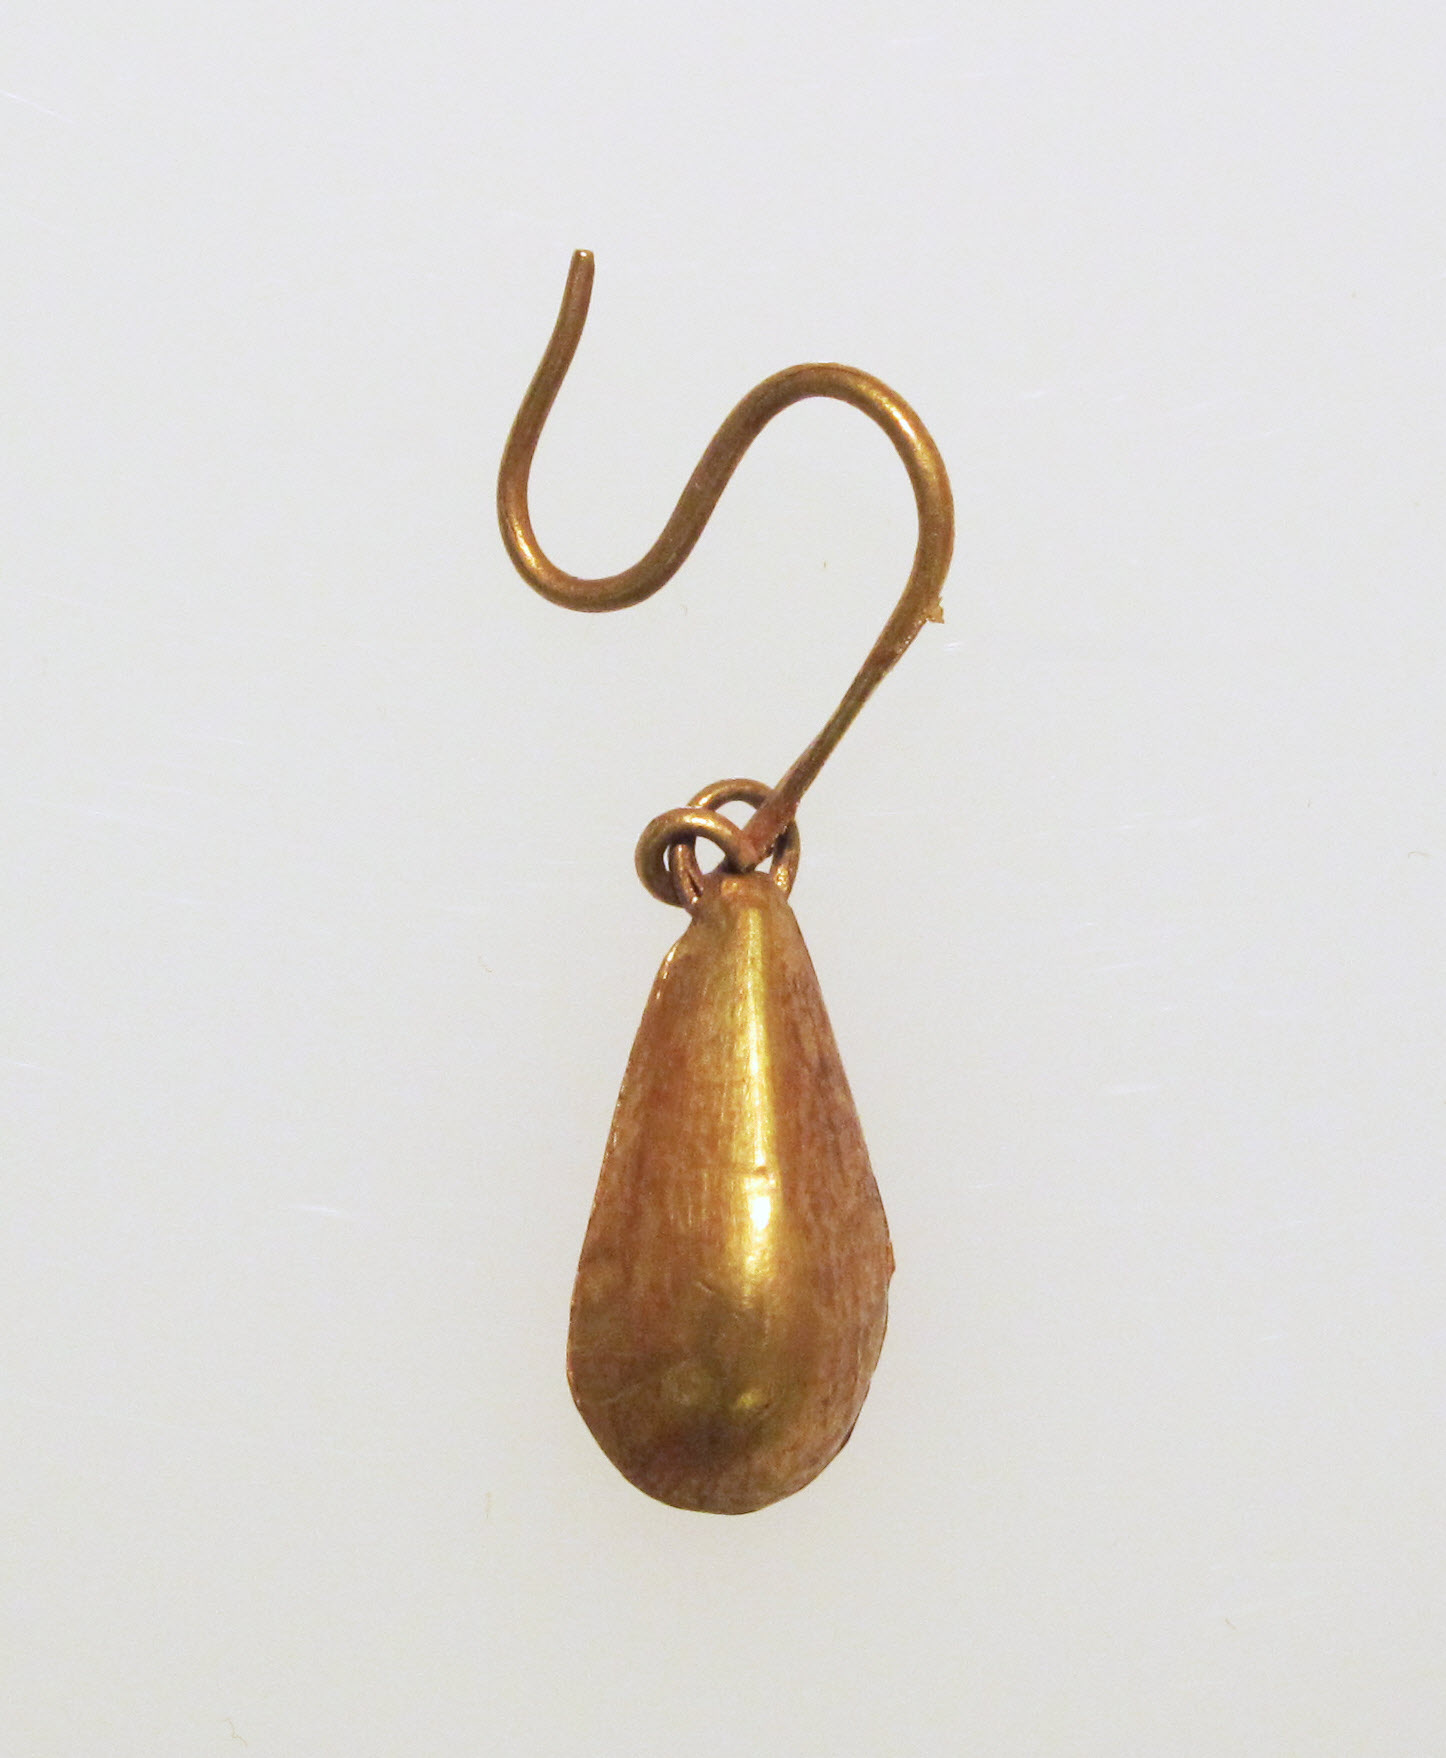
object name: earring hook type with pendant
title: Gold pendant earring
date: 7000 BCE-330 CE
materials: gold